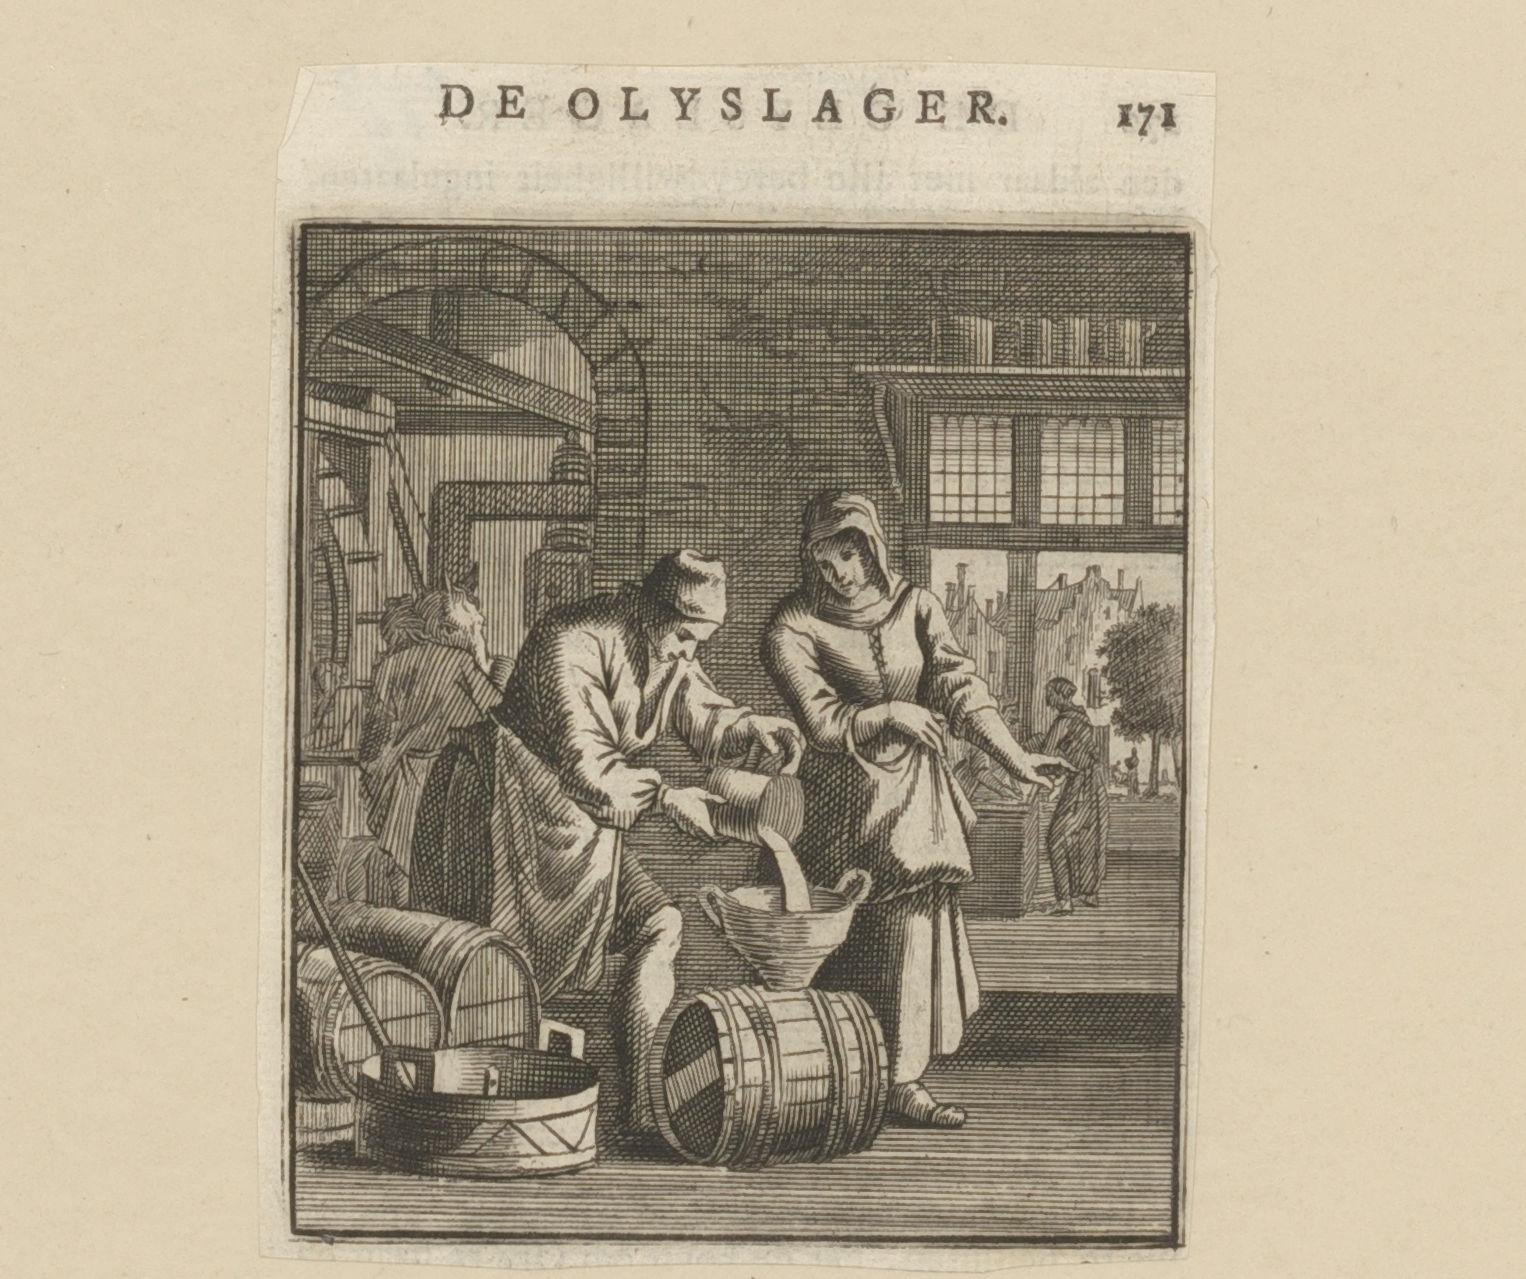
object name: print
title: Olieslager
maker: Anonymous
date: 1719-1759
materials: paper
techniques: etching, letterpress printing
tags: handicrafts, craftsman at work, oil-lamp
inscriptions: collector's mark: Lugt 1641, stamp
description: Prent met andere letterzetting gebruikt in: St. Clara, Abraham van. Iets voor allen. [Vertaald door] J. le Long. Amsterdam: Janssoons van Waesberge, 1719, dl. 2. En in: St. Clara, Abraham van. Iets voor allen. [Vertaald door] J. le Long. Amsterdam: Jan Roman de Jonge, 1741, dl. 2. En in: St. Clara, Abraham van. Iets voor allen. [Vertaald door] J. le Long. Amsterdam: Jan Roman, 1759, dl. 2. Huidige prent uit een andere editie. Naar een prent van: Jan Luyken.